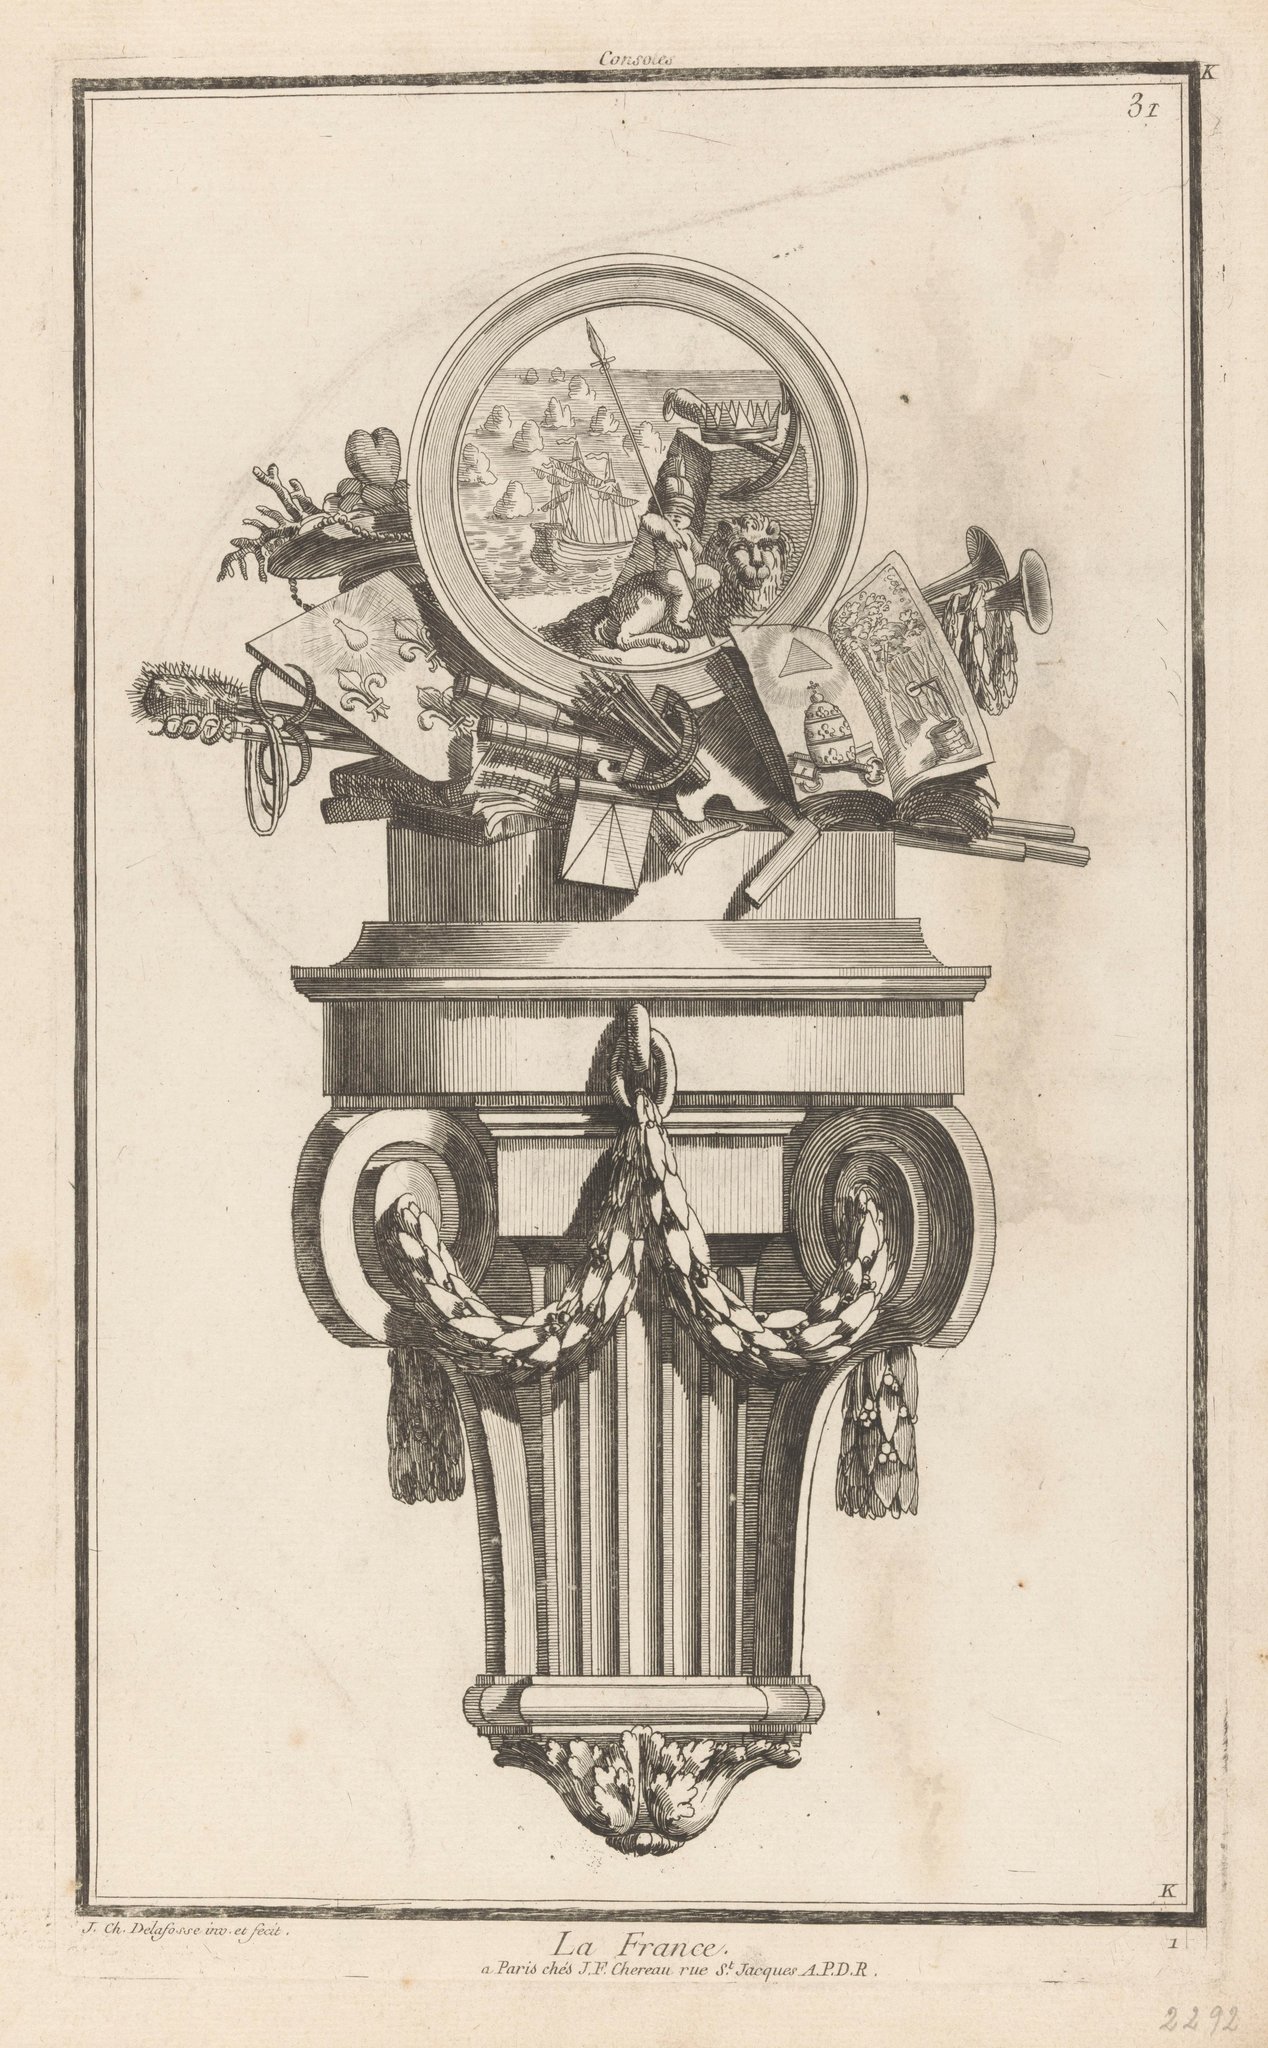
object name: ornament print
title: La France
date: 1768-1771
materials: paper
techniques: engraving, etching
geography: paris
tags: other architectural details (console), france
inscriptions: collector's mark: Lugt 2760, collector's mark: Lugt 2228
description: Een geornamenteerde console met voluten, daarboven diverse wapens, boeken met fleur-de-lis en de pauselijke tiara en een rond medaillon met een geblinddoekte putto met staf op de rug van een leeuw, in de achtergrond een schip op zee. Prentnummer 31.